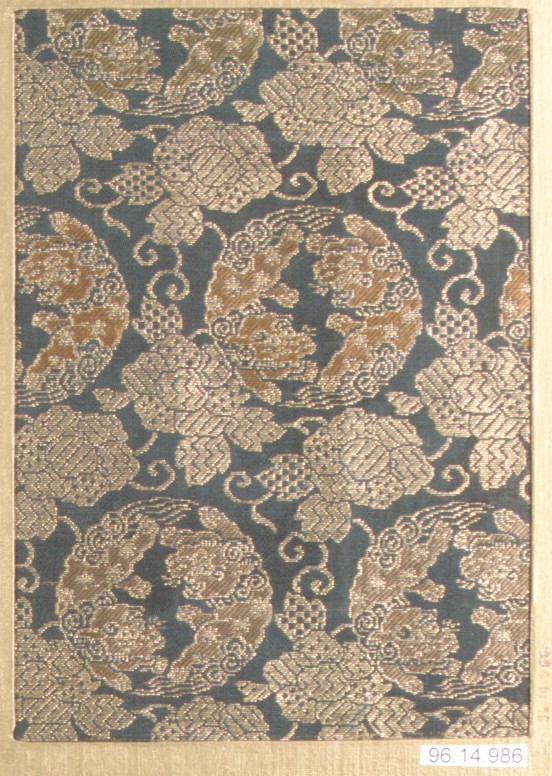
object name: piece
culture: japanese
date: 1701-1900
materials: silk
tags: leaves